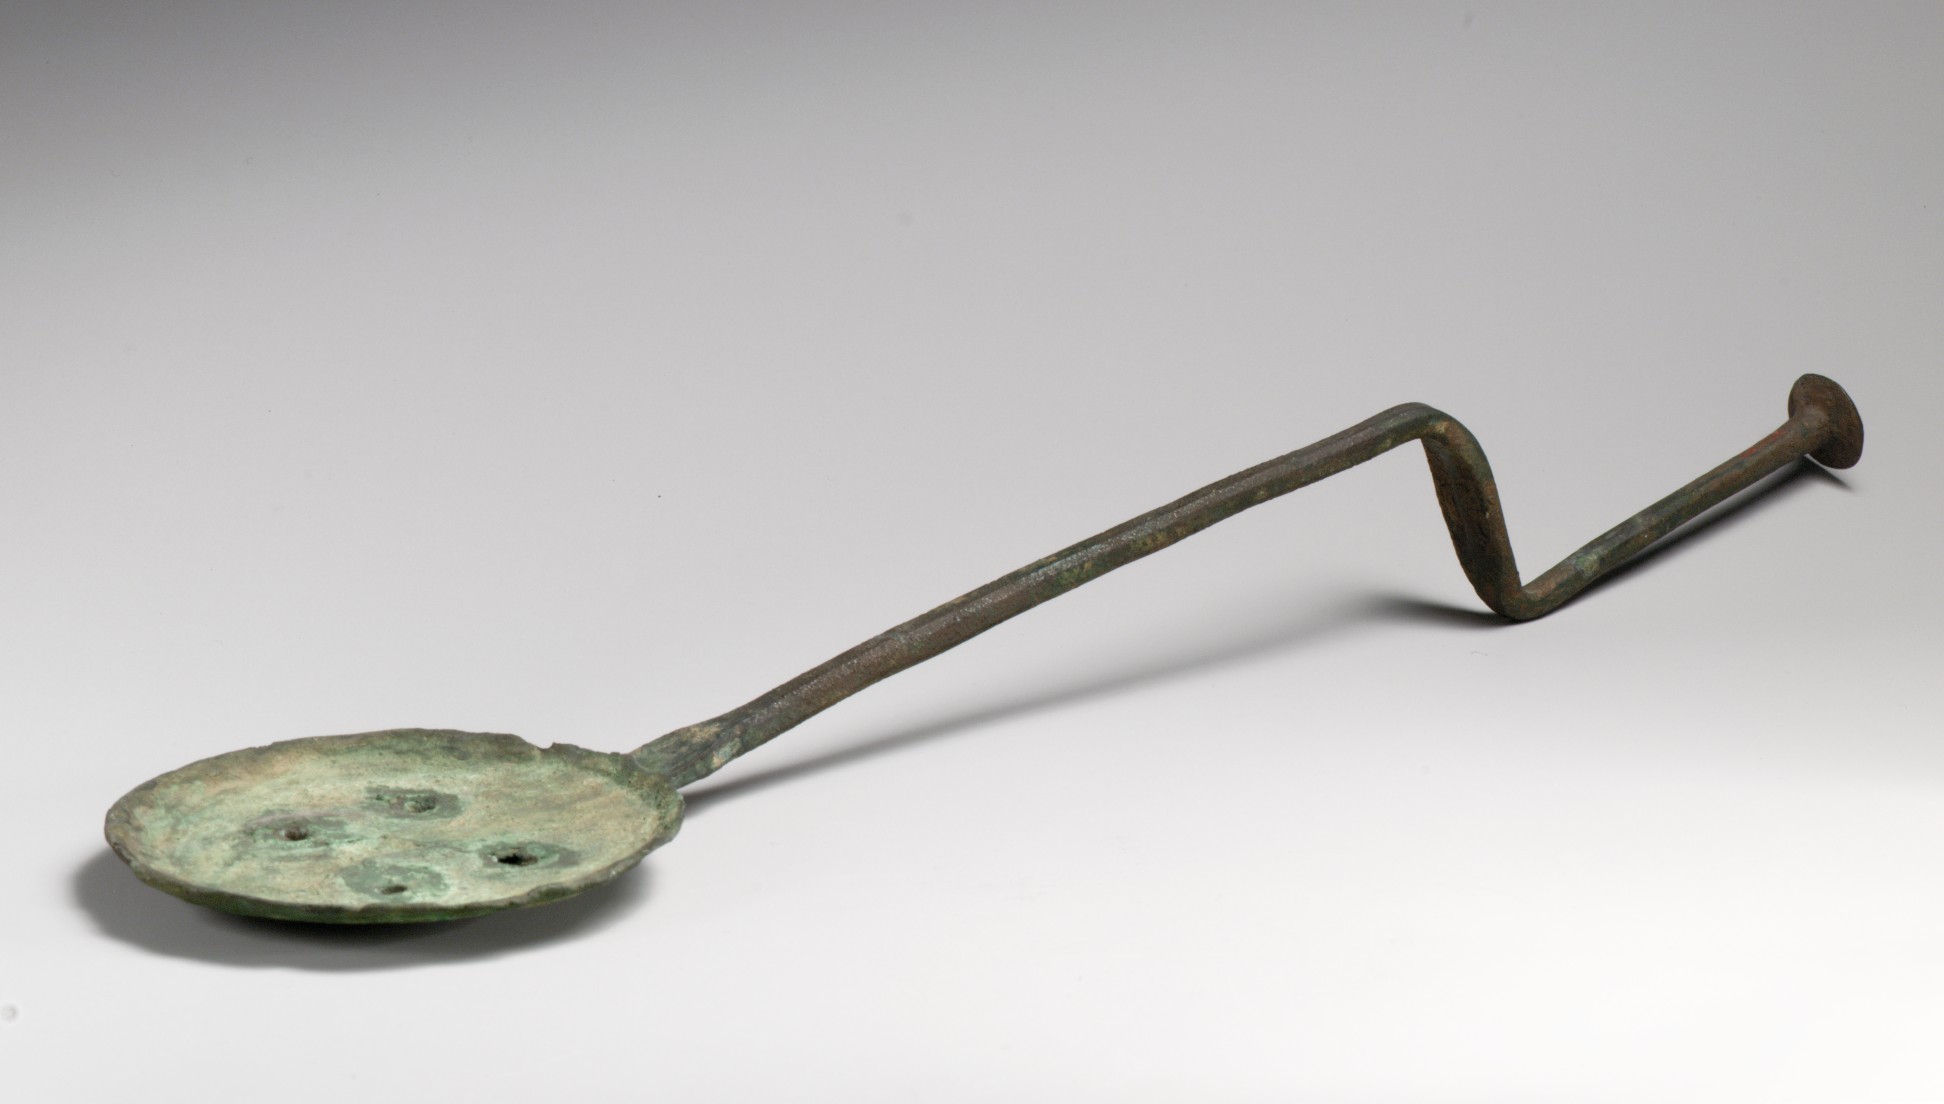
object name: strainer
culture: italic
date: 800-1 BCE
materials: bronze